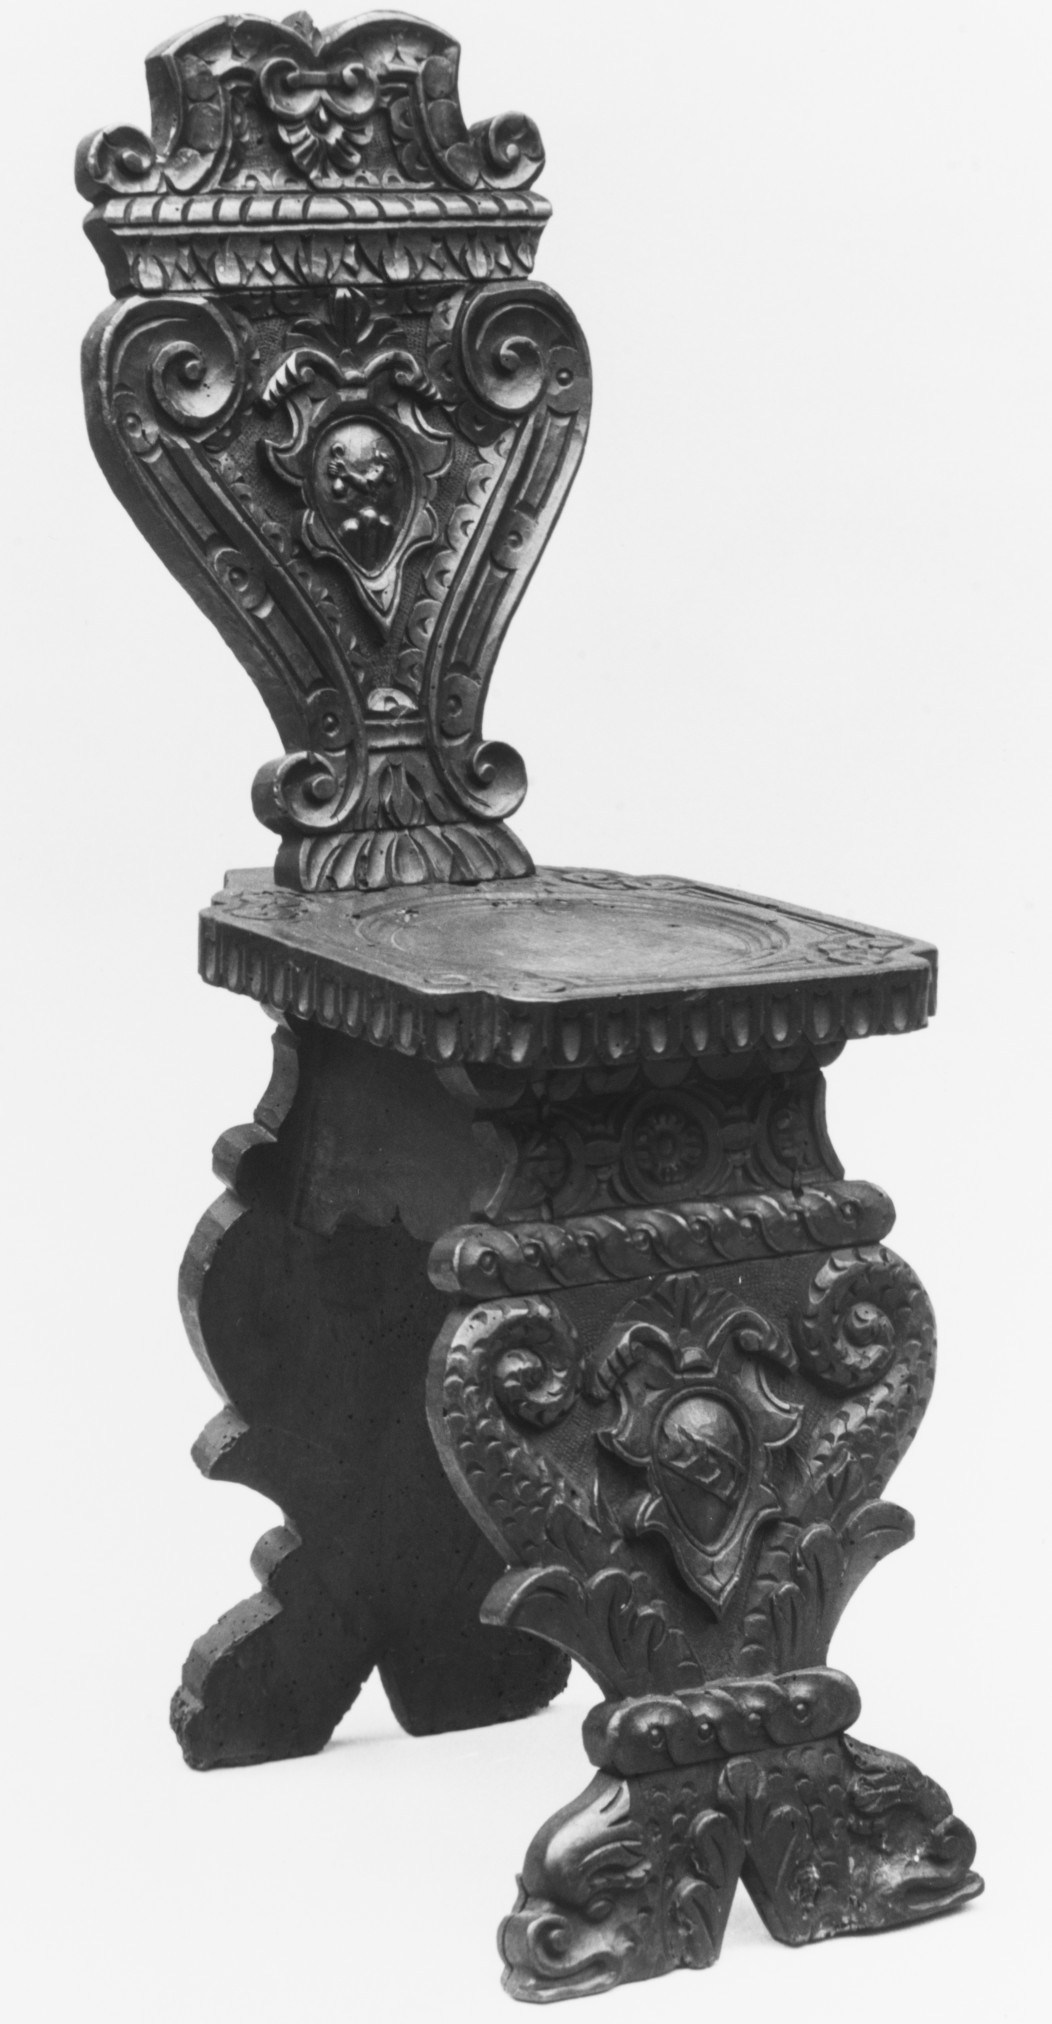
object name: chair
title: Chair (Sgabello)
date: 1501-1600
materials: wood